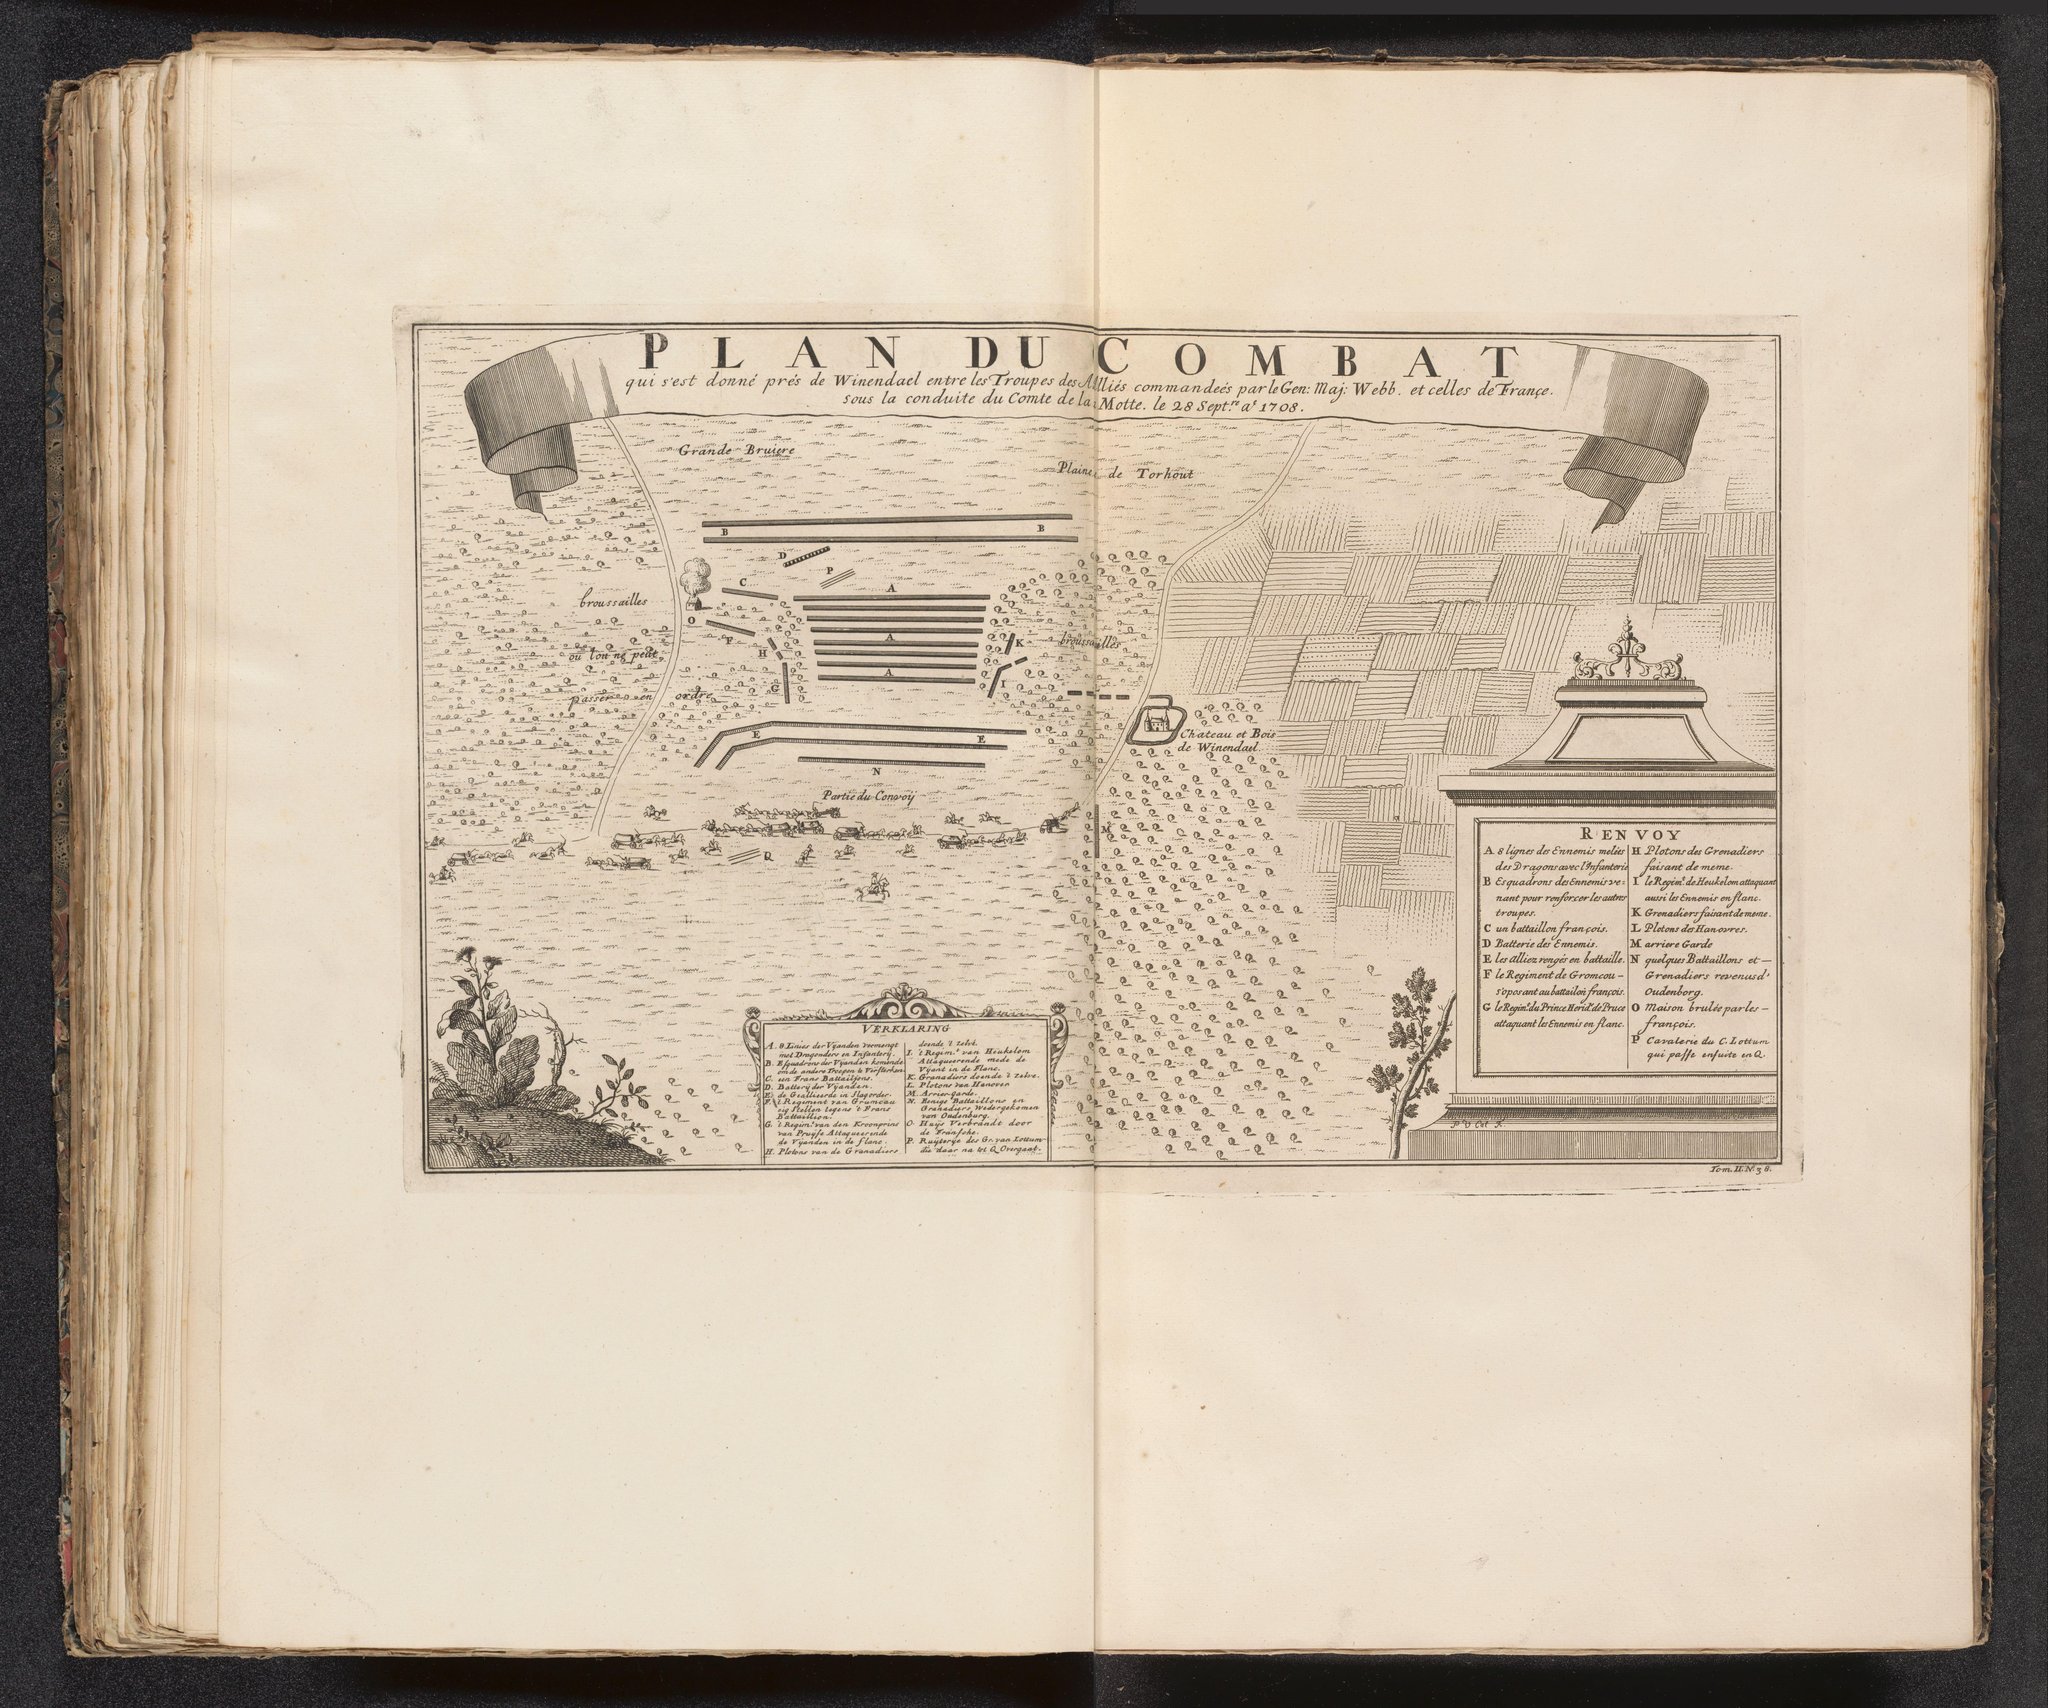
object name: print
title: Plan du Combat qui s'est donné prés de Winendael entre les Troupes des Alliés commandeés par le Gen: Maj: Webb et celles de France sous la conduite du comte de la Motte. le 28 Sept.re ae 1708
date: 1708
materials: paper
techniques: etching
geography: northern netherlands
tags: johan willem friso (prins van oranje-nassau), john churchill (1e hertog van marlborough), maps of separate countries or regions, battle (+ land forces)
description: Plattegrond van de slag op 28 september 1708 bij Wijnendale in West-Vlaanderen tussen de geallieerde troepen onder generaal-majoor Webb die een konvooi begeleidden en Franse troepen onder Graaf de la Motte. Onderaan de legenda's A-P in het Nederlands en Frans. Genummerd rechtsonder: Tom. II. No. 38. Illustratie in het tweede deel van : [Jean] du Mont, Oorlogskundige beschryving van de veldslagen en belegeringen, der drie ... wydvermaarde krygsoversten... den Prins Eugenius van Savoye, den ... Hertog van Marlborough, en den Prins van Oranje en Nassau-Vriesland, in de editie van 1729. Dit tweede deel is hoofdzakelijk gewijd aan de daden van de hertog van Marlborough en prins Johan Willem Friso.